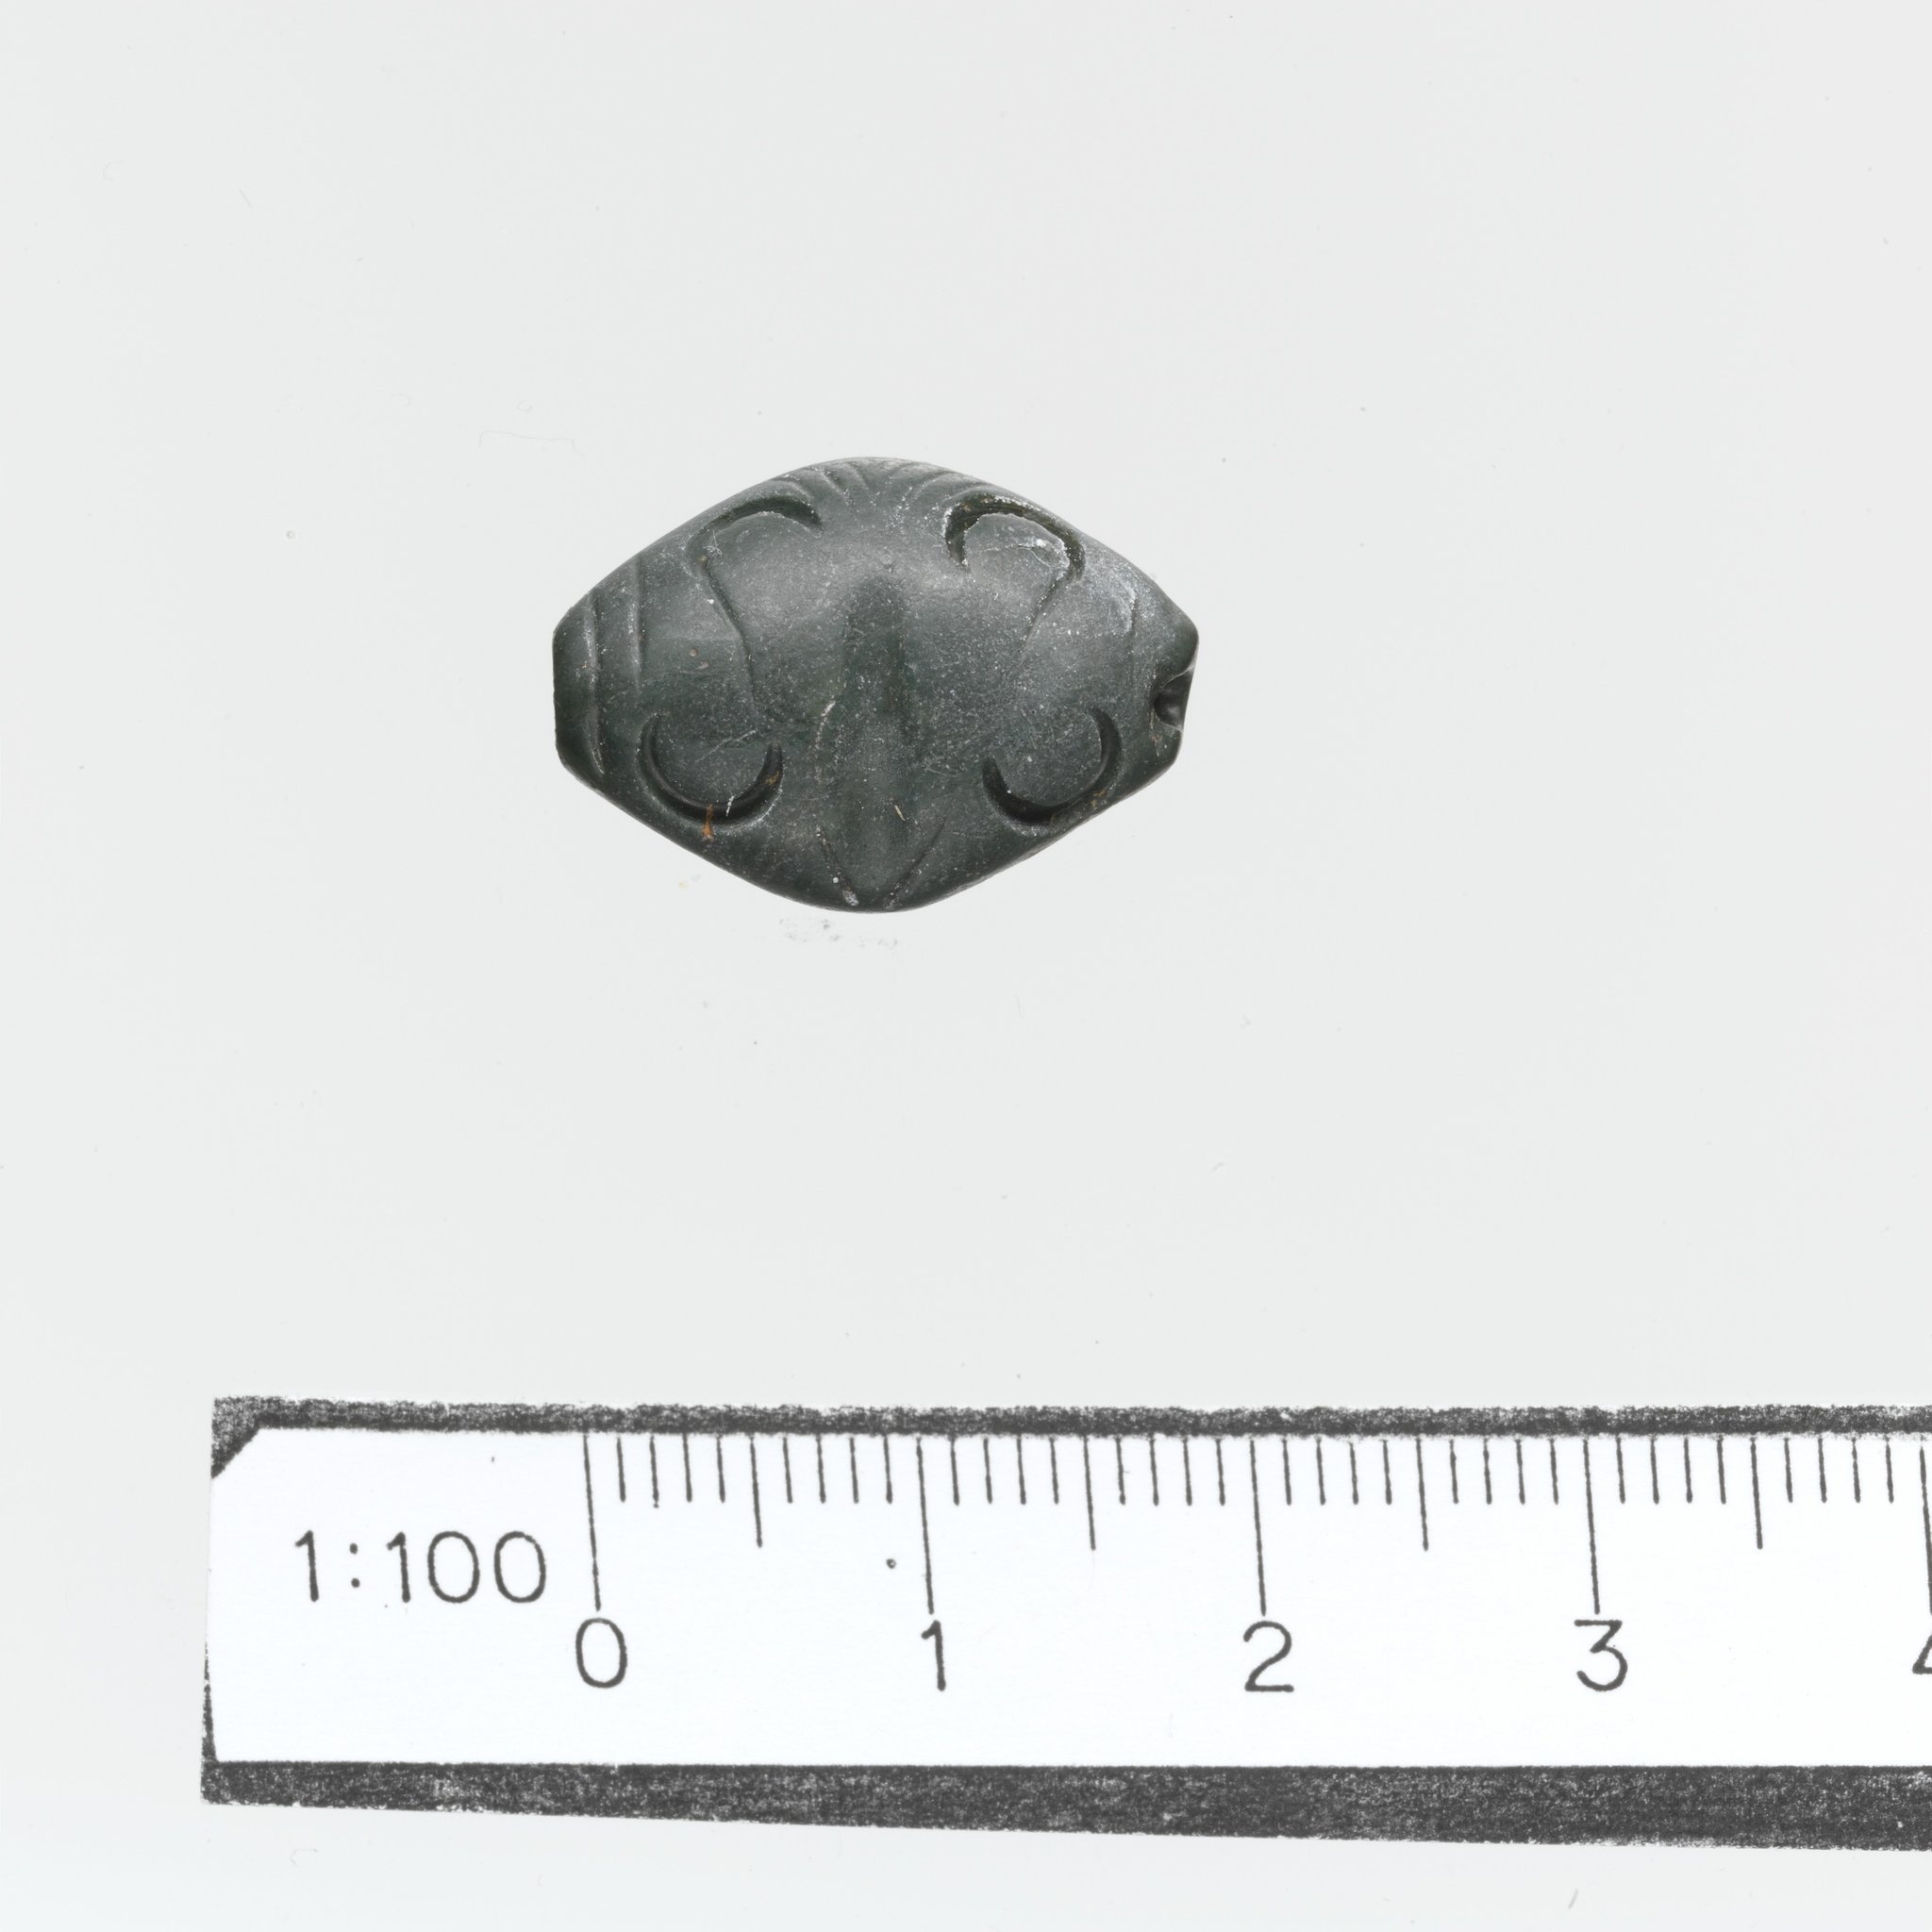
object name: seal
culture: minoan, crete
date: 2000-1450 BCE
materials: jasper